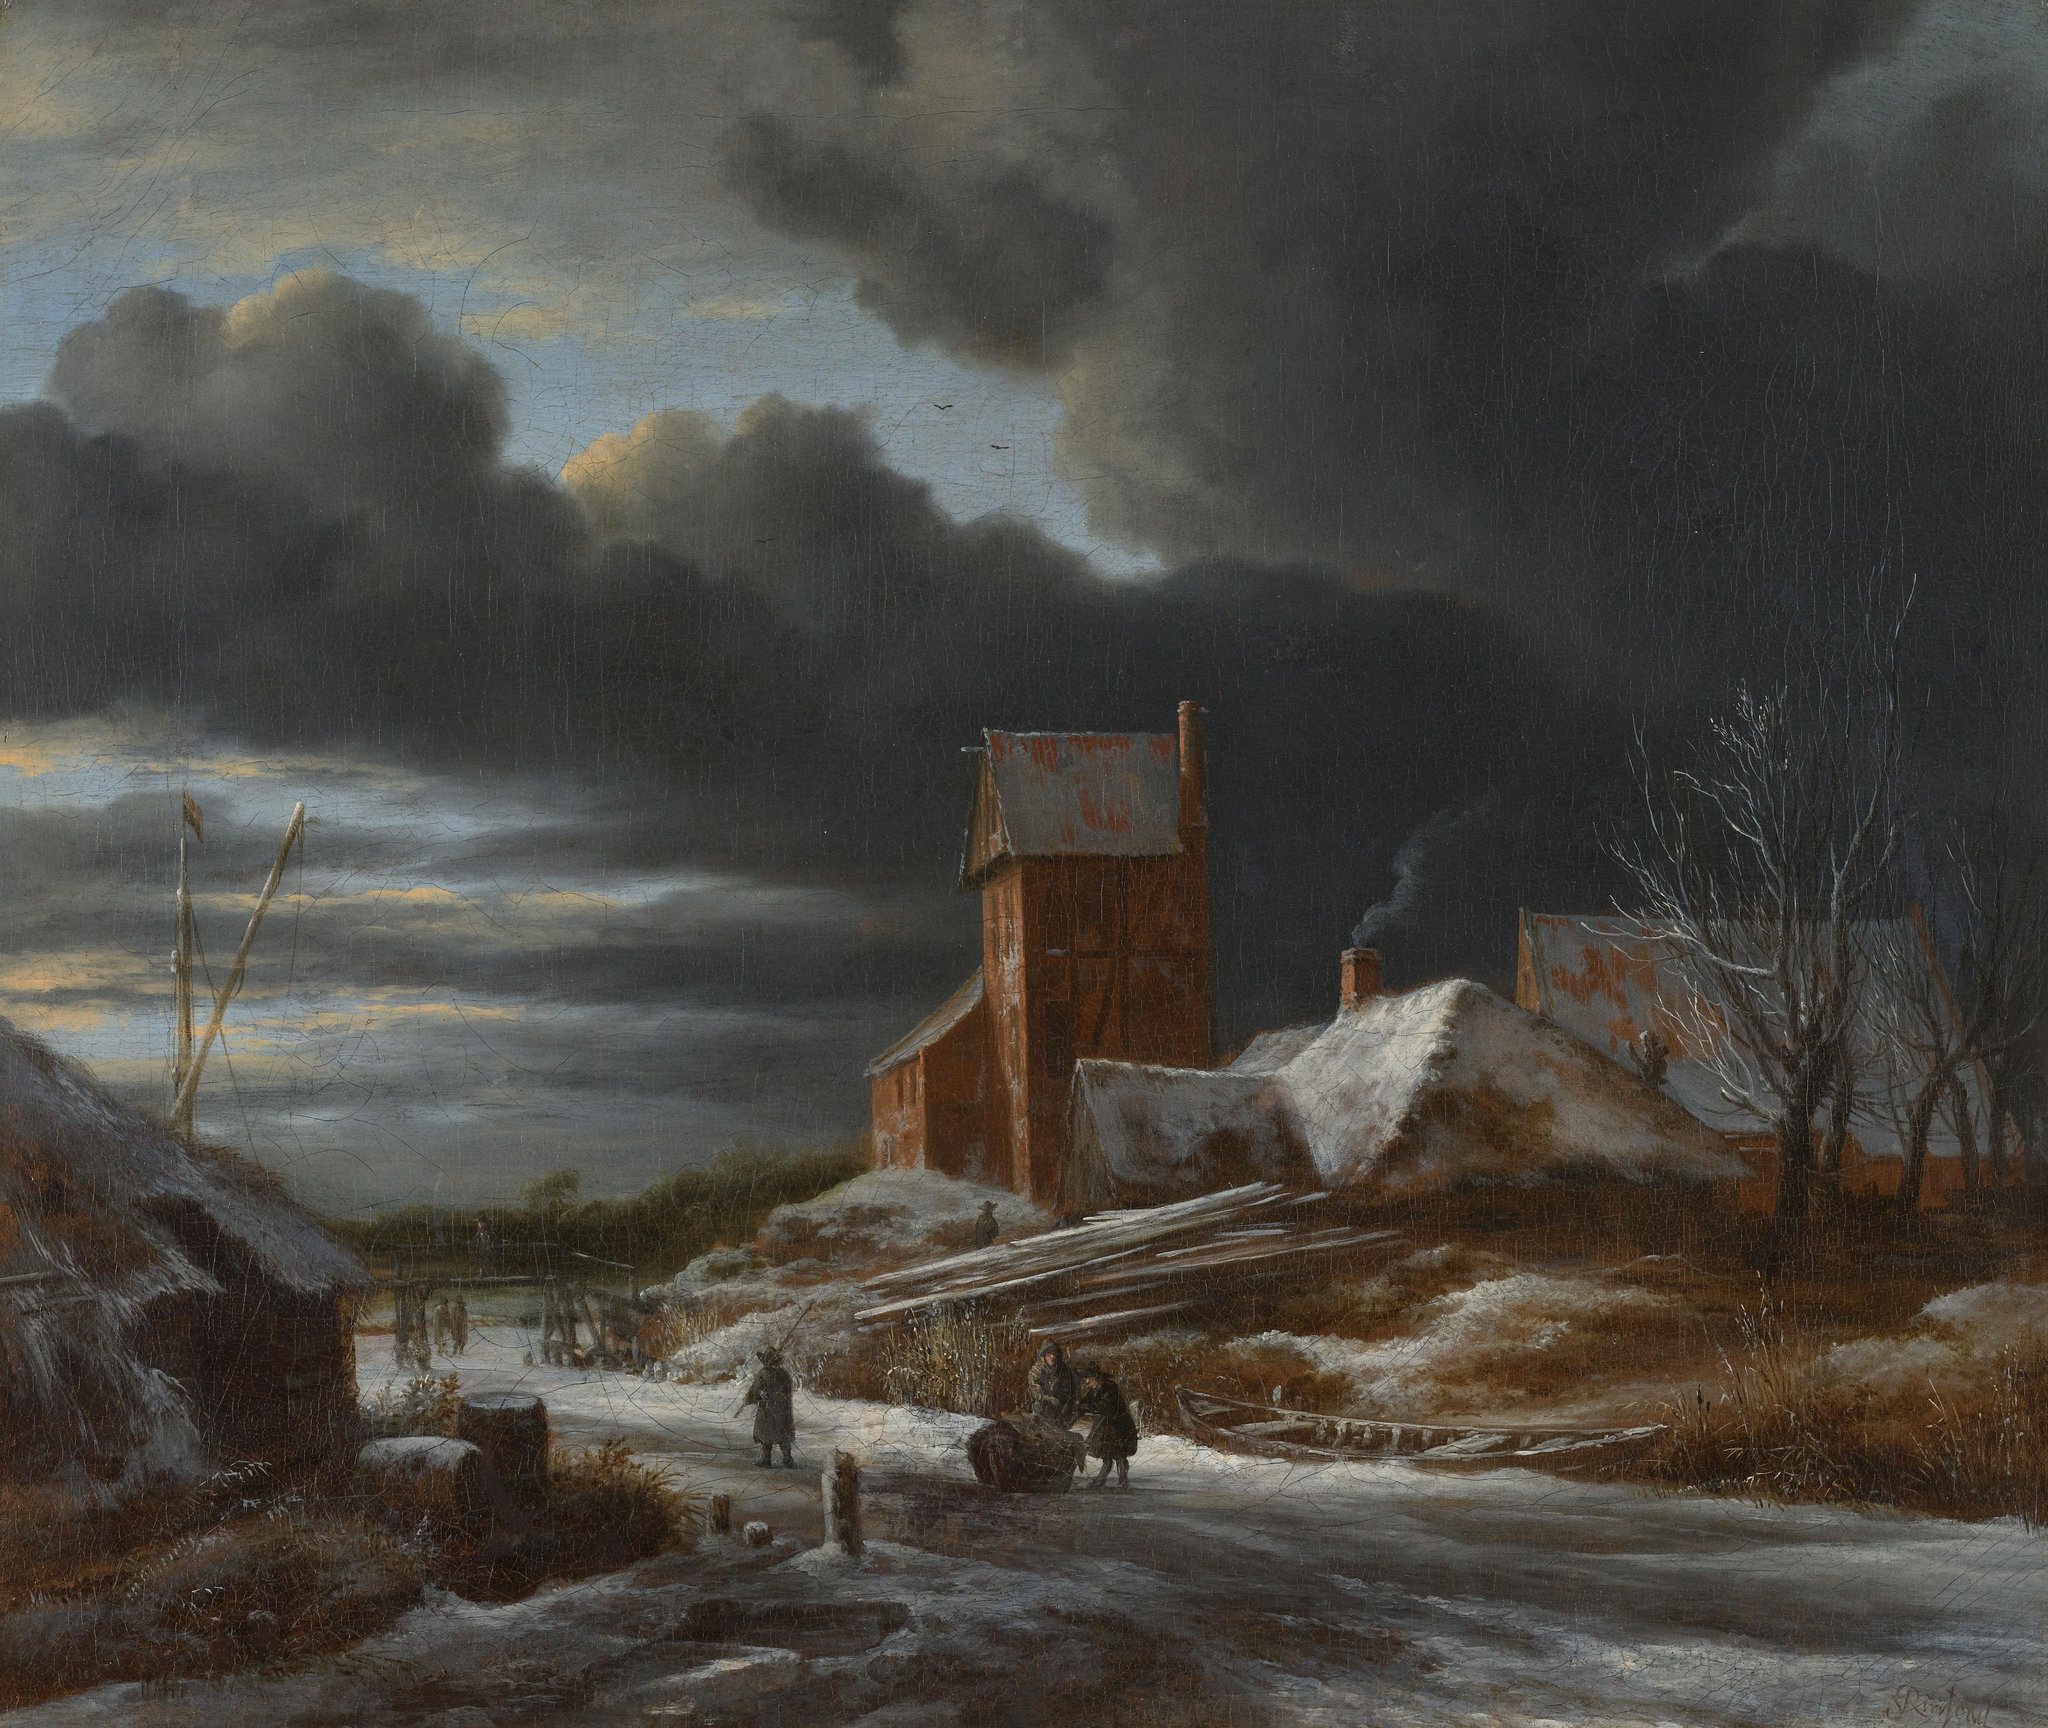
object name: painting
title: Winter landscape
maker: jacob isaacksz van ruisdael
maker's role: draughtsman, painter, print maker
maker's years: 1628-1682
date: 1665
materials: canvas, oil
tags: sleigh, sledge (non-sport), ice ~ freezing weather, winter landscape; landscape symbolizing winter (the four seasons of the year)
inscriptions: signature: ‘JVRuisdael’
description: Ruisdael painted around 25 winter landscapes. This scene is dominated by ominous dark clouds, and lit from the left by low, raking sunlight. The warmly dressed figures on the ice seem insignificant in the face of this inclement weather. A cheerful crowd of ice skaters would have been out of place in such a wintery landscape by Ruisdael.